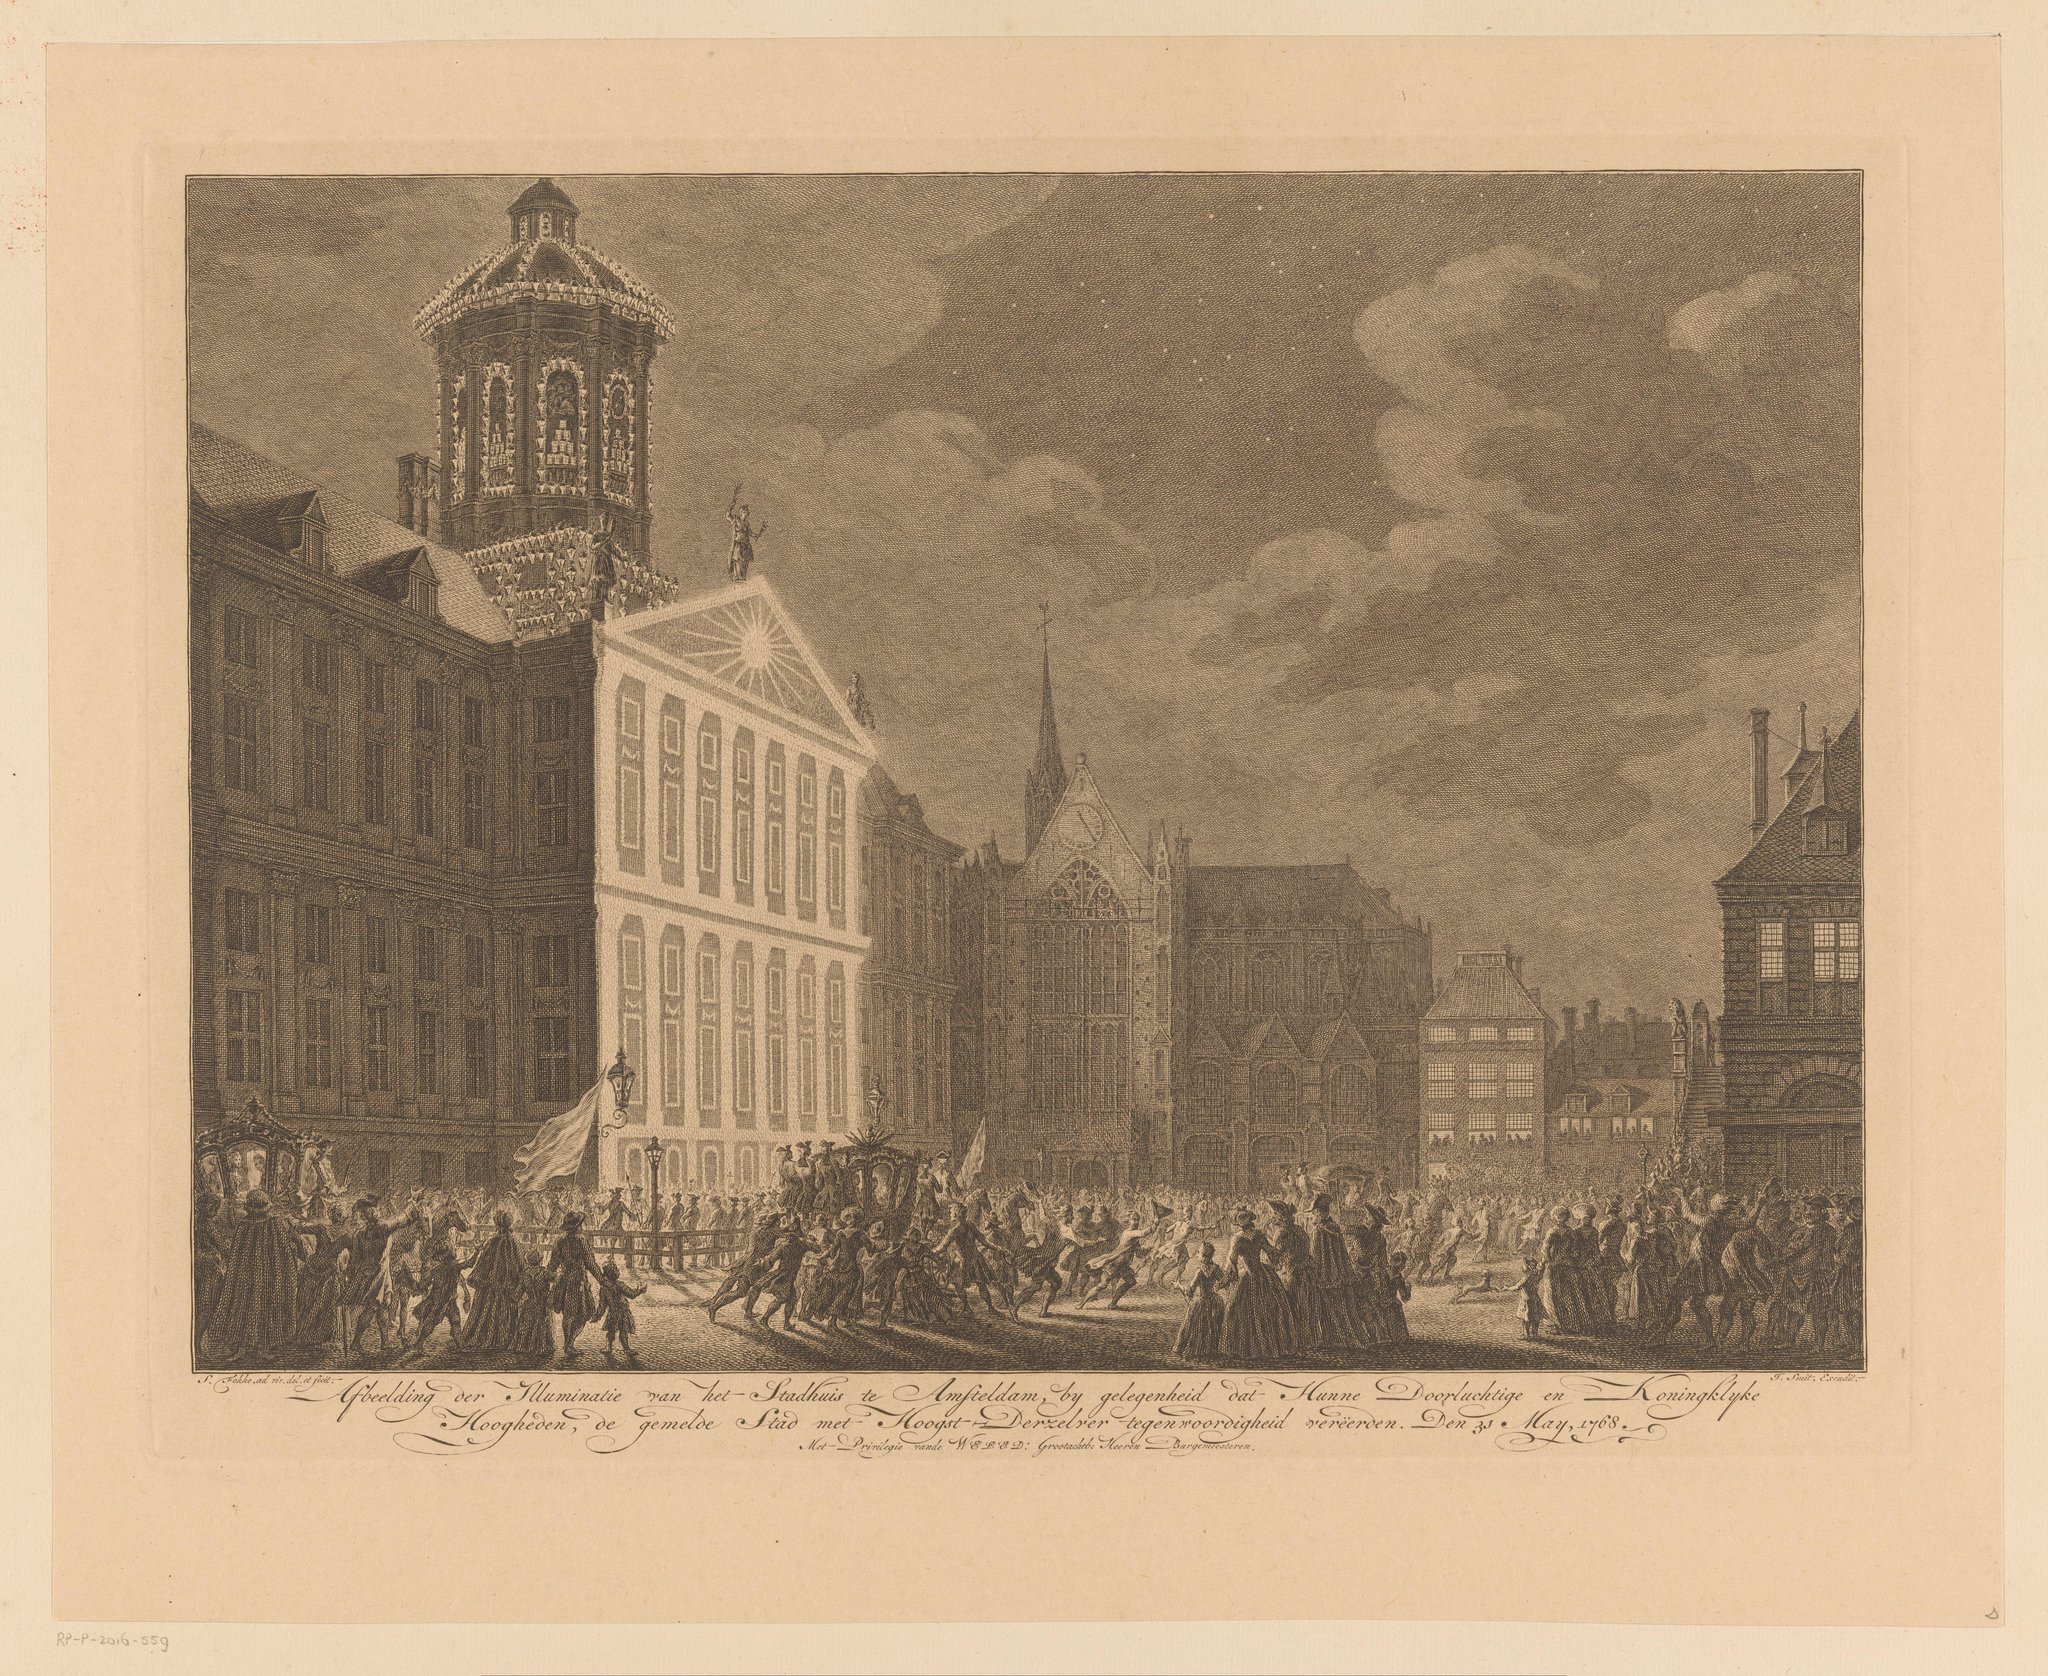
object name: print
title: Illuminatie van het stadhuis voor Willem V en Wilhelmina van Pruisen, 1768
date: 1772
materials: paper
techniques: engraving, etching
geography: amsterdam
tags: william v (prince of orange), draughtsman, wilhelmina of prussia (princess of orange), public festivities on the occasion of royal events (+ illumination, fire-works ~ festive activities), decoration and illumination of streets, squares, etc. (~ triumphal entry, etc.)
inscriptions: collector's mark: Lugt 2228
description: Illuminatie van de voorgevel en toren het stadhuis op de Dam, op 31 mei 1768. Met de aankomst van de koets met het prinselijk paar voor het stadhuis.